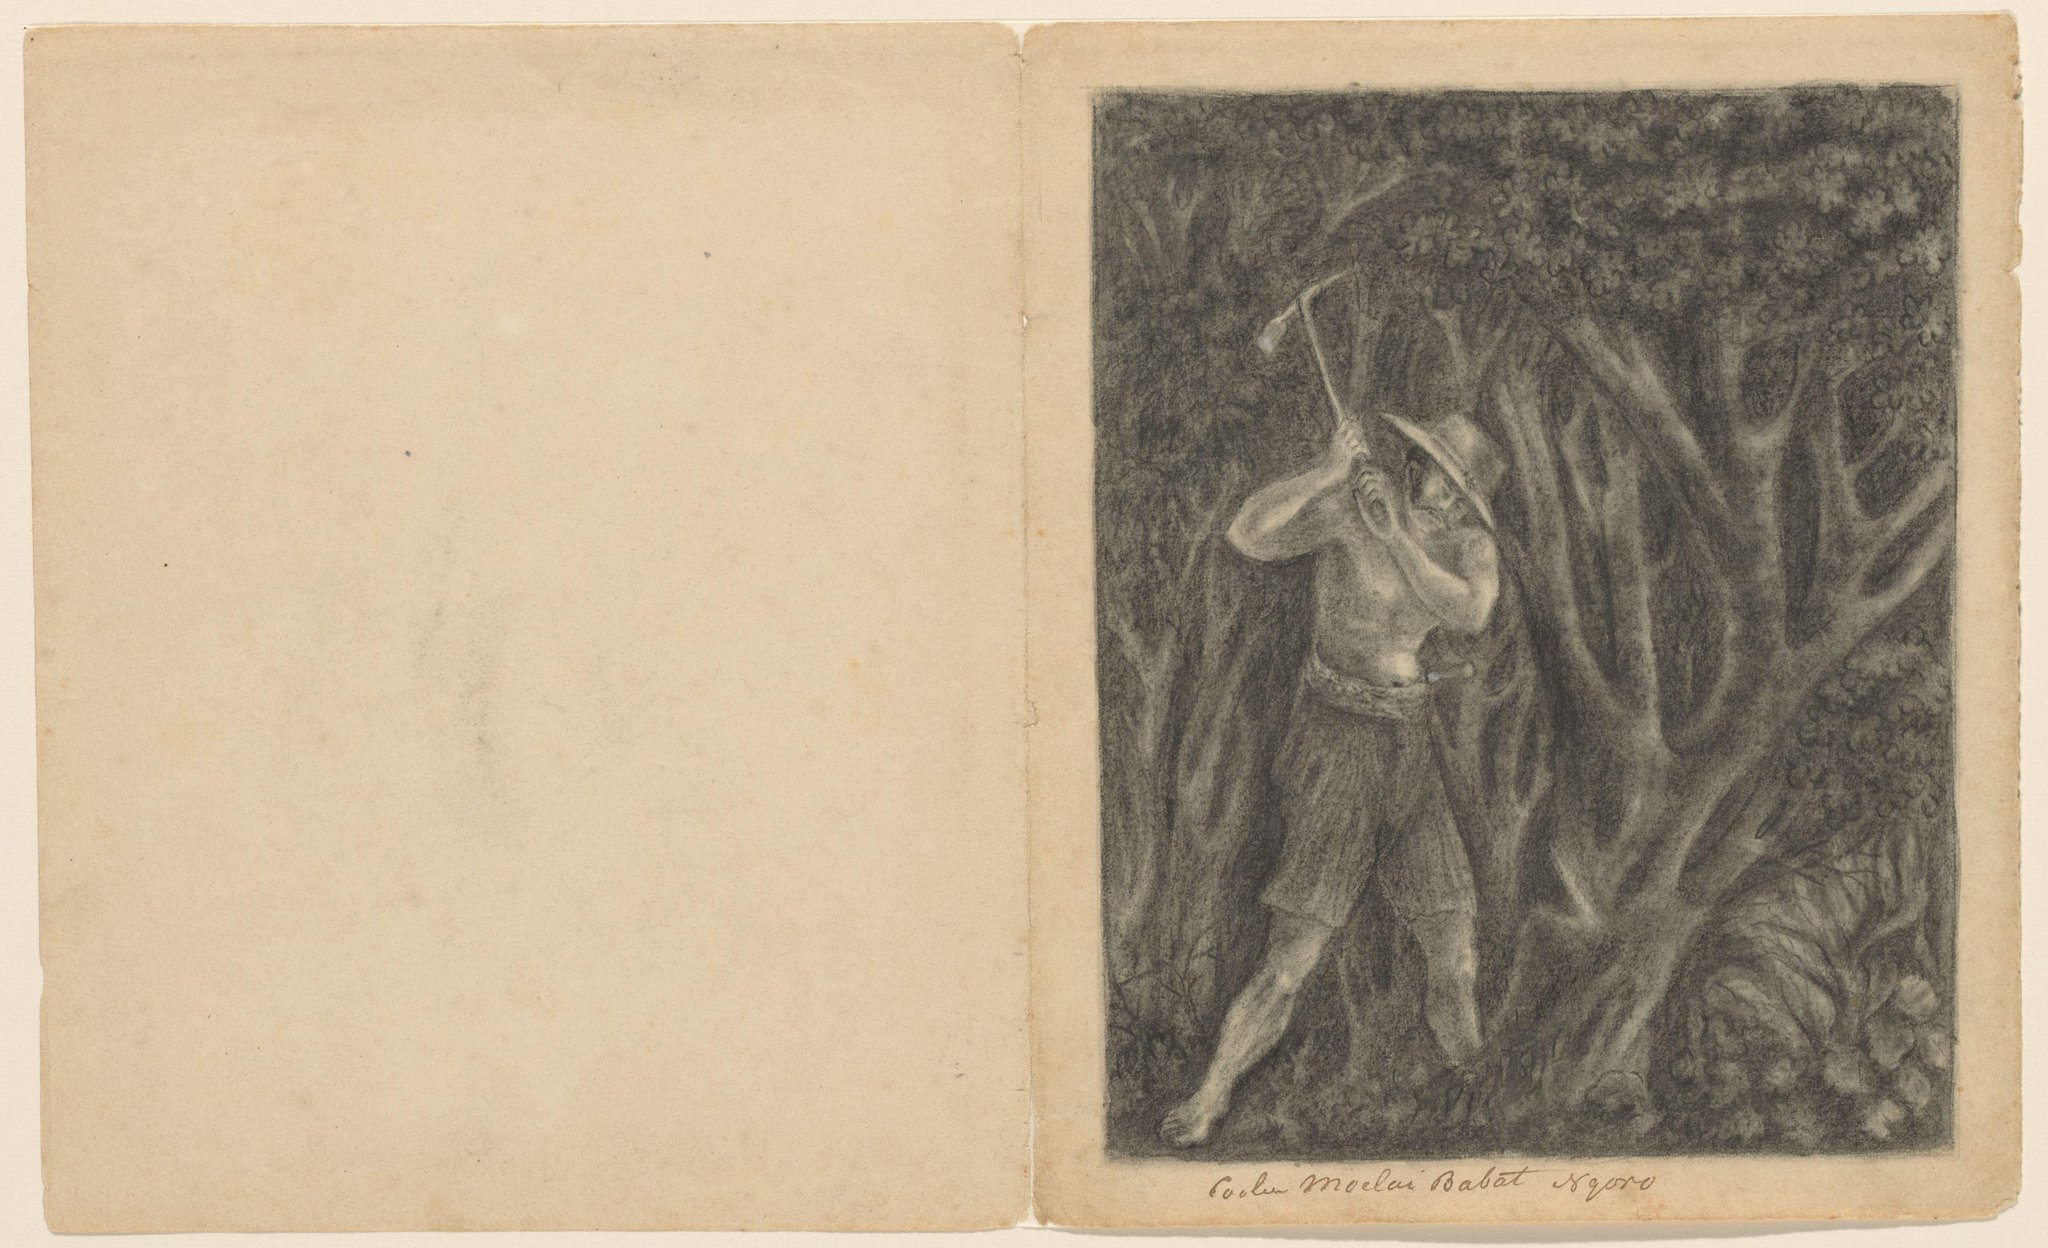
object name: drawing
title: Coolen begin een bos te kappen te Ngoro, ca. 1820-1850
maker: Anonymous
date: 1850-1950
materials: chalk, paper, pencil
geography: indonesia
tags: java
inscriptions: collector's mark: Lugt 2228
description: Coolen begin een bos te kappen te Ngoro. Onderdeel van een groep van twaalf losse bladen uit een schetsboek met tekeningen over het leven van Coenraad Laurens Coolen, evangelist op Oost-Java, ca. 1820-1850. Elk blad heeft een tekening op de rechterhelft, met een onderschrift in het Indonesisch.